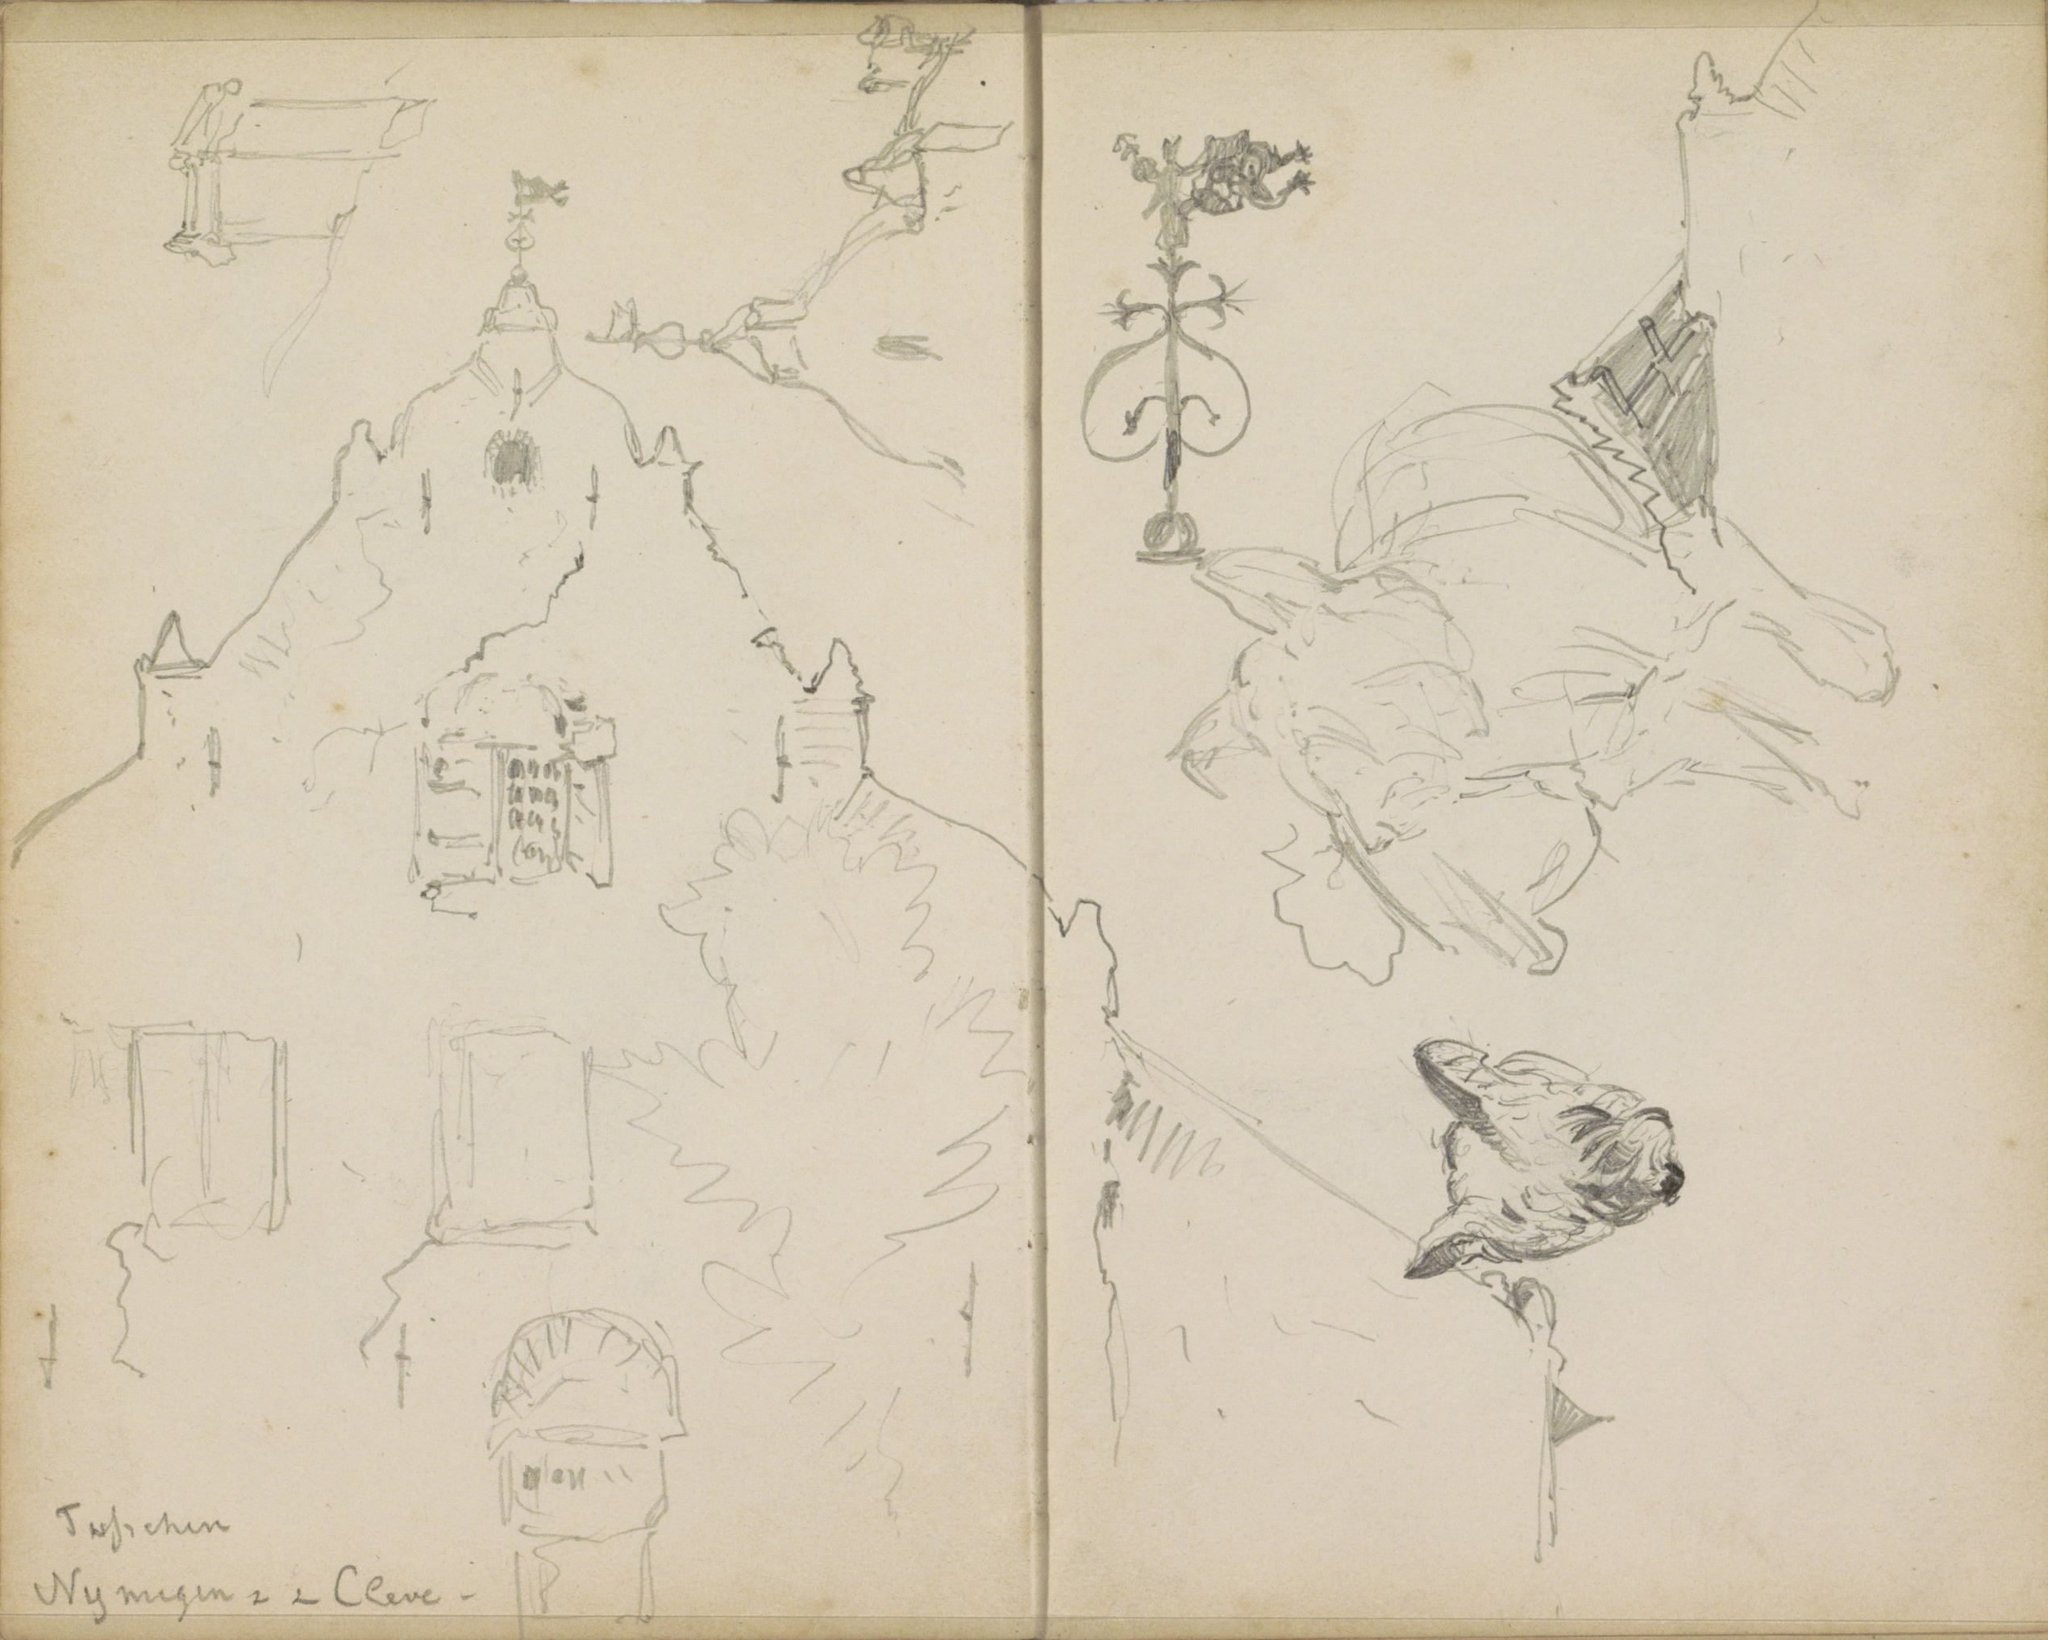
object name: sketchbook leaf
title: Architectuurstudies en honden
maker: johannes tavenraat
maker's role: draughtsman, painter, print maker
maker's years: 1809-1881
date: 1839-1872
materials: paper, pencil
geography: nijmegen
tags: architecture, dog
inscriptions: annotation: ‘Tusschen/ Nijmegen & & Cleve -’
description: Blad 43 verso en 44 recto uit een schetsboek met 73 bladen.